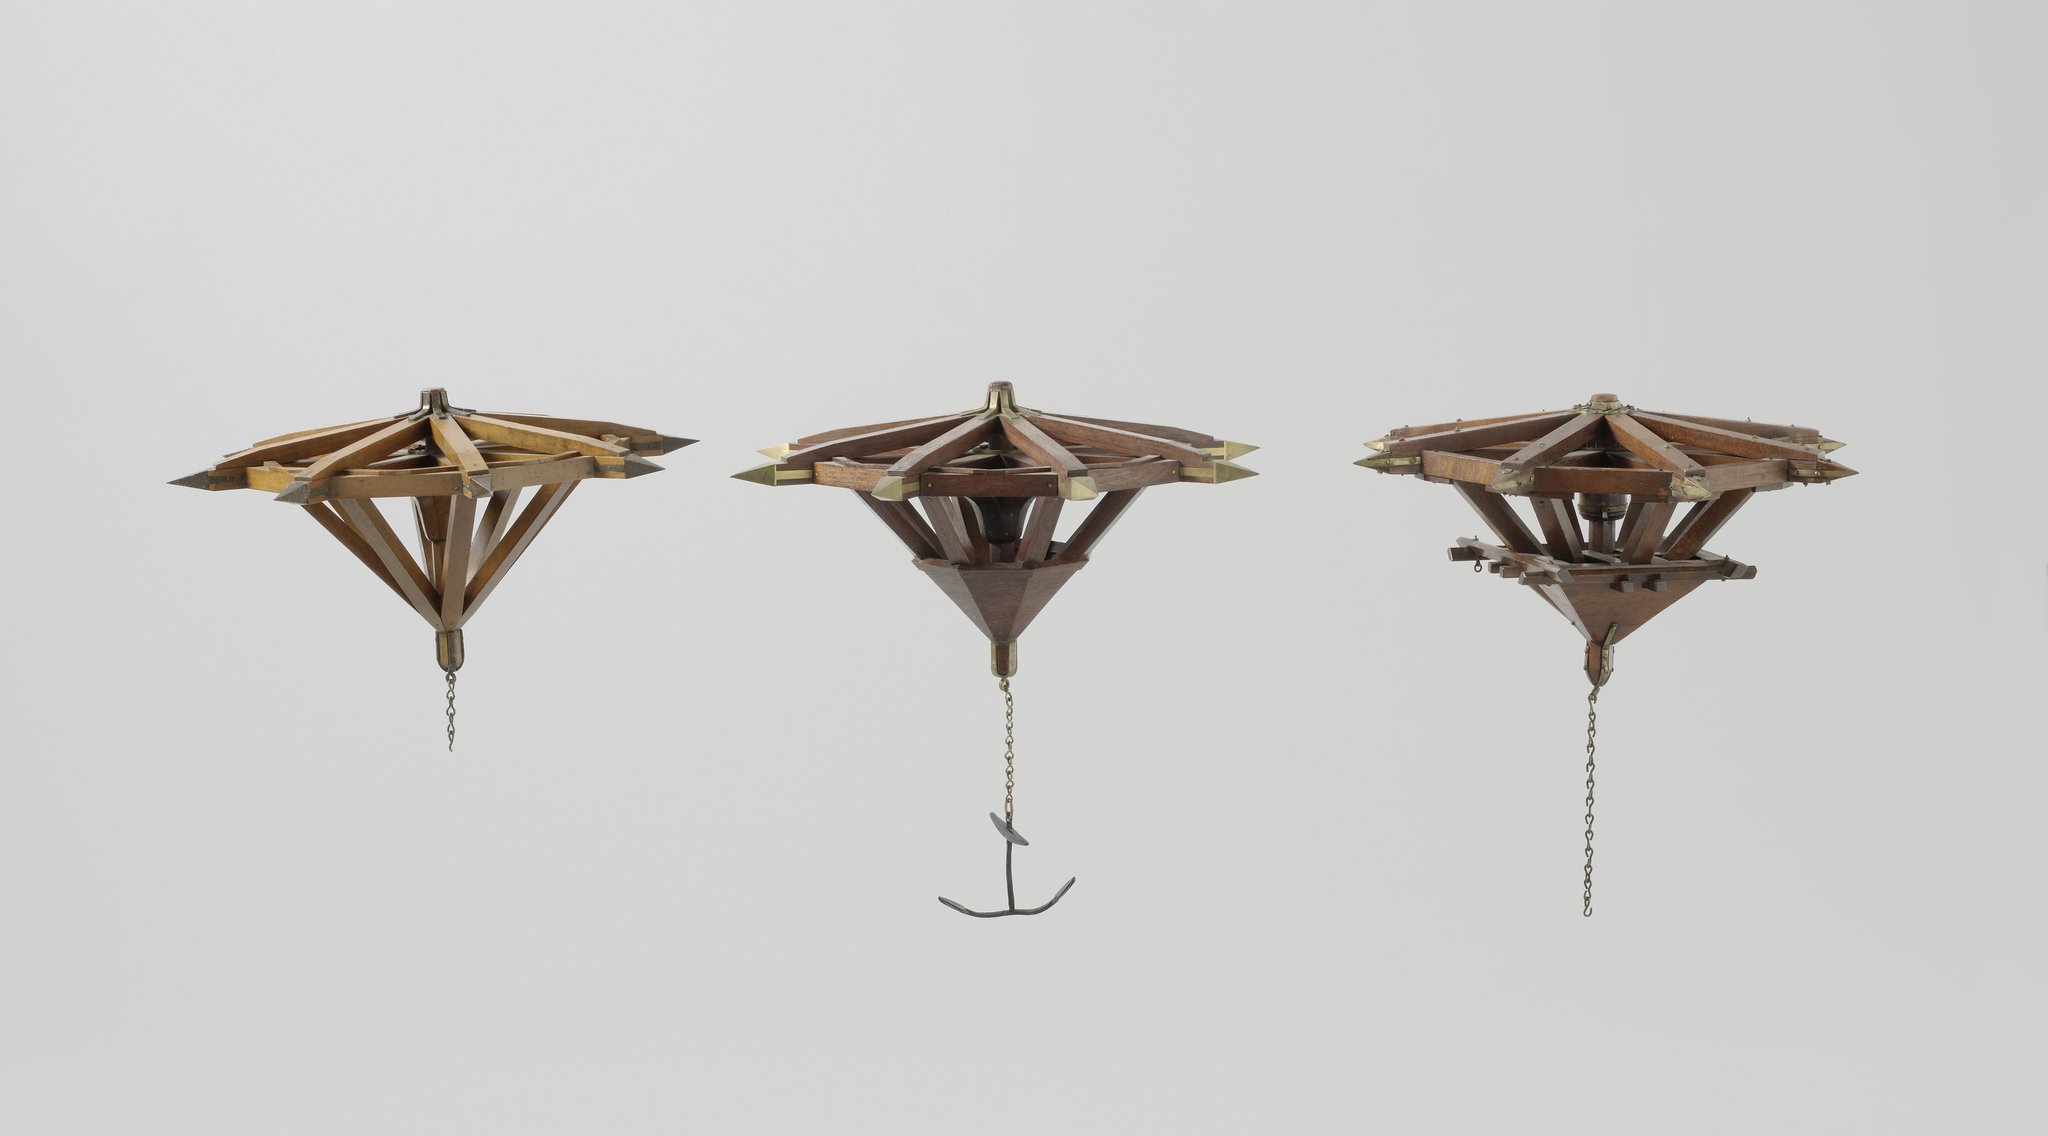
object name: demonstration model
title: Model of an Artificial Reef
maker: Anonymous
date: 1799-1800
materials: brass, iron, lead, wood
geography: netherlands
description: Kunstklippen of 'haspels' waren een uitvinding van H. Aeneae, lid van het Comité Central van de Marine van de Bataafse Republiek. Geankerd en net onder het wateroppervlak drijvend moesten zij de havens tegen vijandelijke schepen versperren. Een werd gebouwd en beproefd in de haven van het Nieuwediep, maar de kettingen waaraan de kanons, dienst doend als ankers, vastgemaakt waren hielden het niet en het gevaarte moest op het droge gesleept worden. Toen tijdens een storm een hospitaalschip tegen de klip aandreef, werd de klip beschadigd en niet het schip. De Zweedse admiraal Cronsaedt was geïnteresseerd in het ontwerp voor de verdediging van de Sont en de Belten en verkreeg hiervoor tekeningen en een beschrijving, evenals de Italiaanse ingenieur Salvini. .